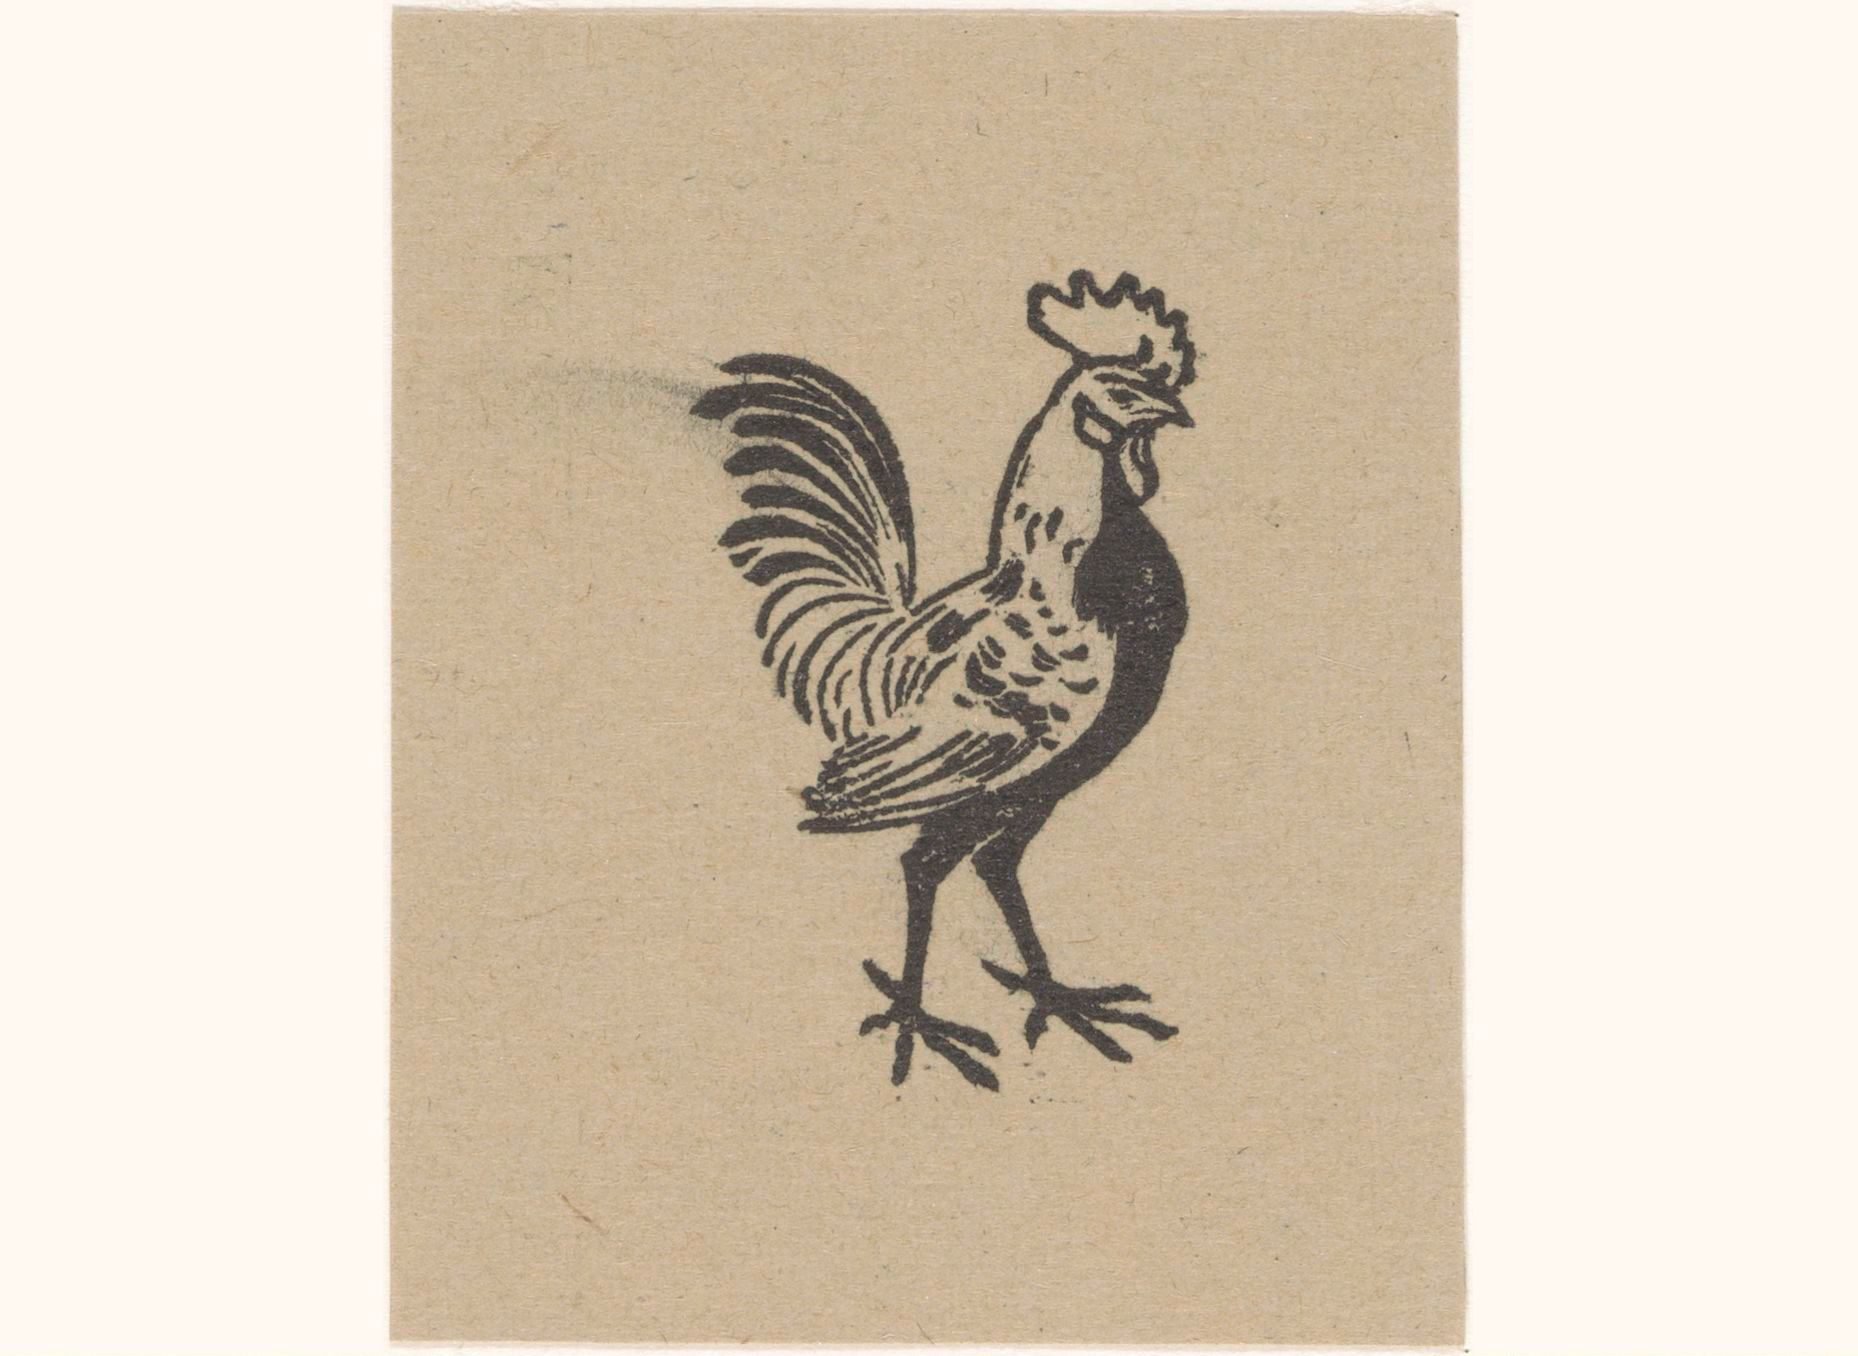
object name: print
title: Haan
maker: julie de graag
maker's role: draughtsman, print maker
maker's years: 1877-1924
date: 1901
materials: paper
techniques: woodcut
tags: fowl (cock, hen, chicken, etc.)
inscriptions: collector's mark: Lugt 2228